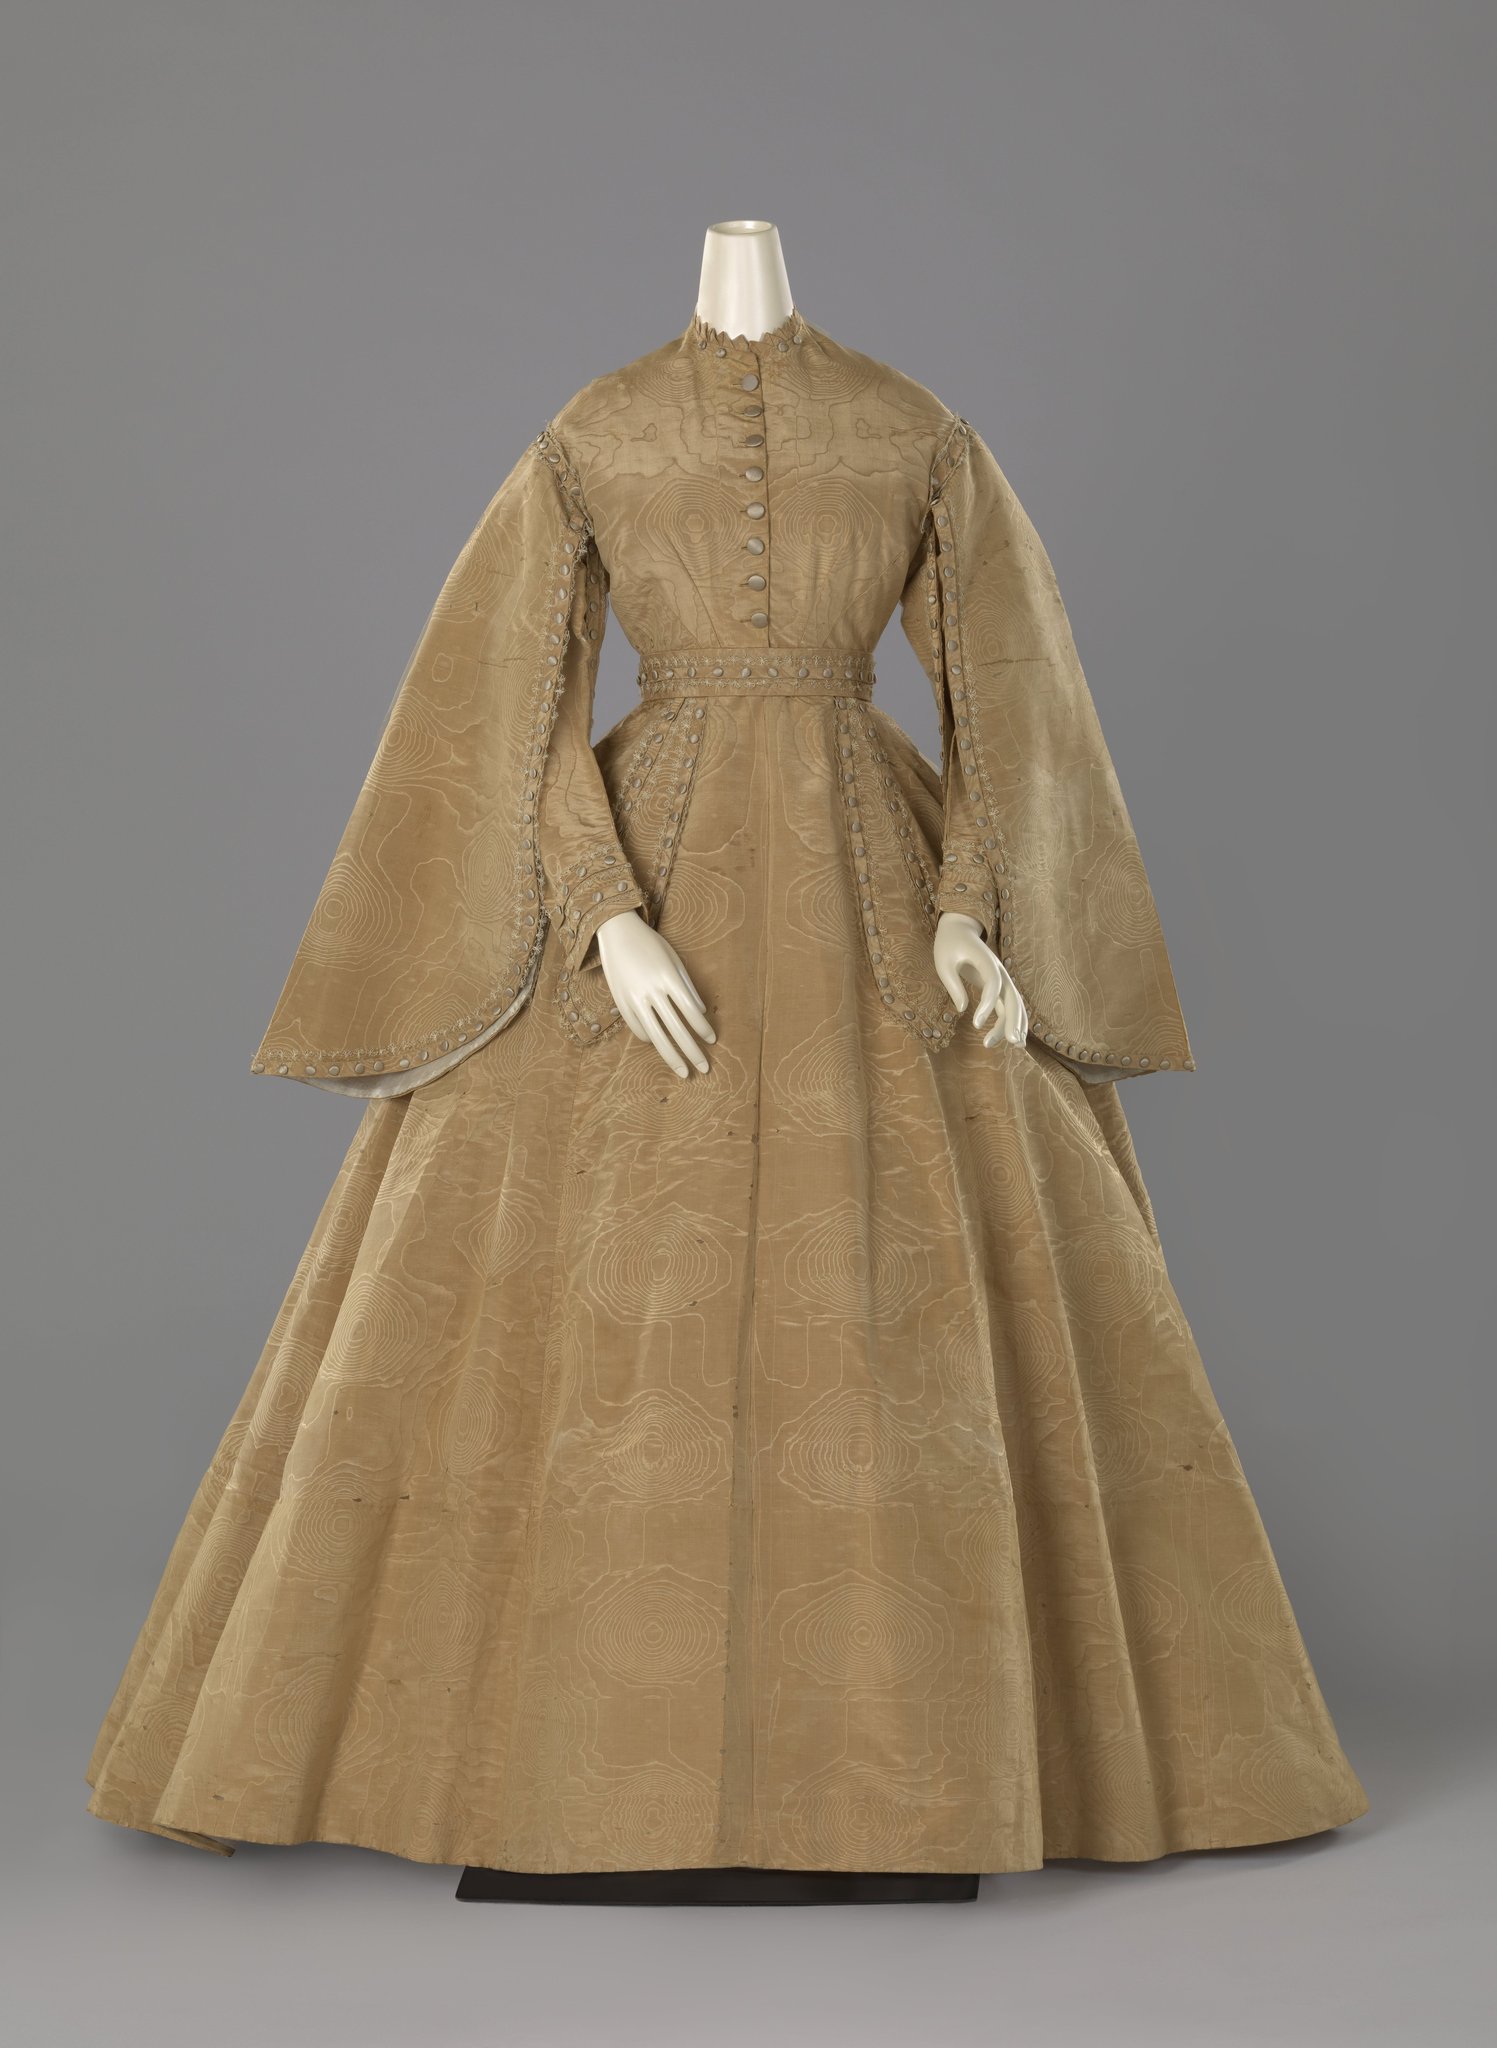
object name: womenswear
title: Ceintuur met lange slippen met franje en versierd met kleine knopen, overtrokken met goudkleurige stof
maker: Anonymous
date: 1865-1870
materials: silk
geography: europe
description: Ceintuur met lange slippen met franje en versierd met kleine knopen, overtrokken met goudkleurige stof. De ceintuur hoort bij japon (A).